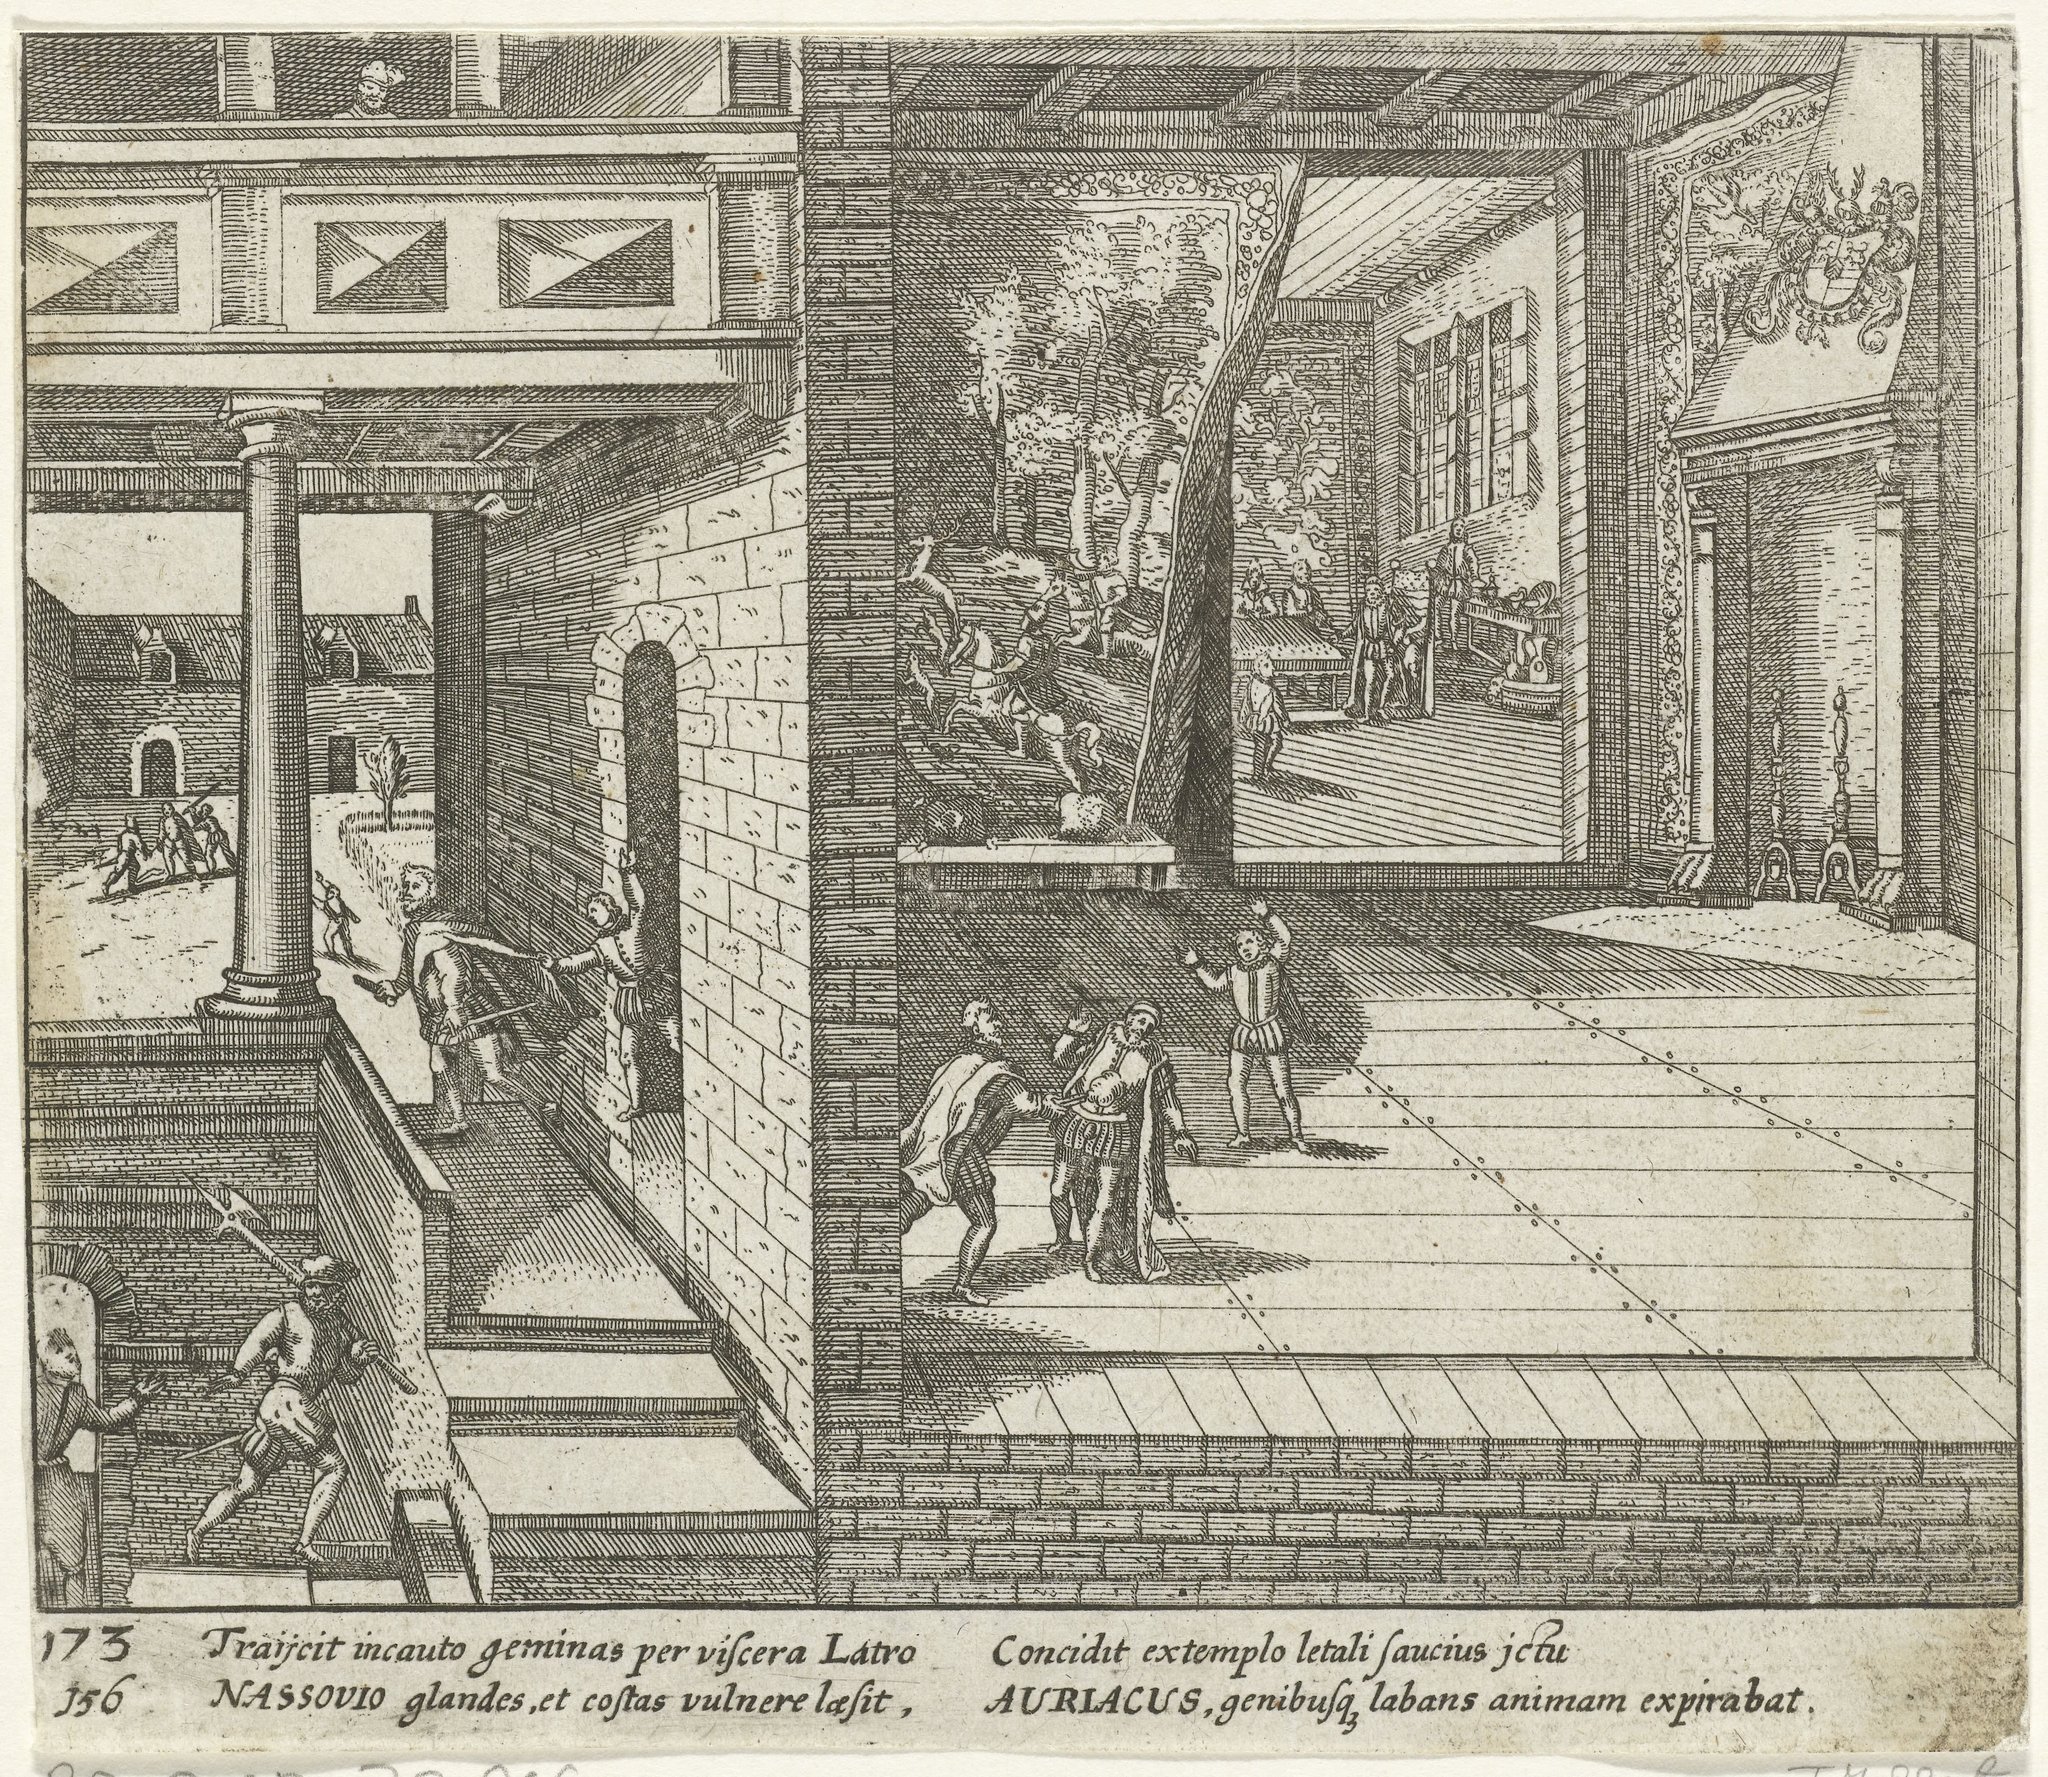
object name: history print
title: De moord op Willem van Oranje, 1584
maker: Anonymous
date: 1613-1615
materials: paper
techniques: etching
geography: northern netherlands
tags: delft, william i (prince of orange), attempt, political murder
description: Willem van Oranje vermoord door Balthasar Gerards, 10 juli 1584. Gezicht op interieur Prinsenhof: achter ontvangt de prins Gerards in een kamer, op de voorgrond wordt de prins neergeschoten. Links probeert Gerard te ontsnappen en wordt hij gevangengenomen. Met onderschrift van 4 regels in het Latijn. Genummerd 156 en 173. Onbedrukt op achterzijde.